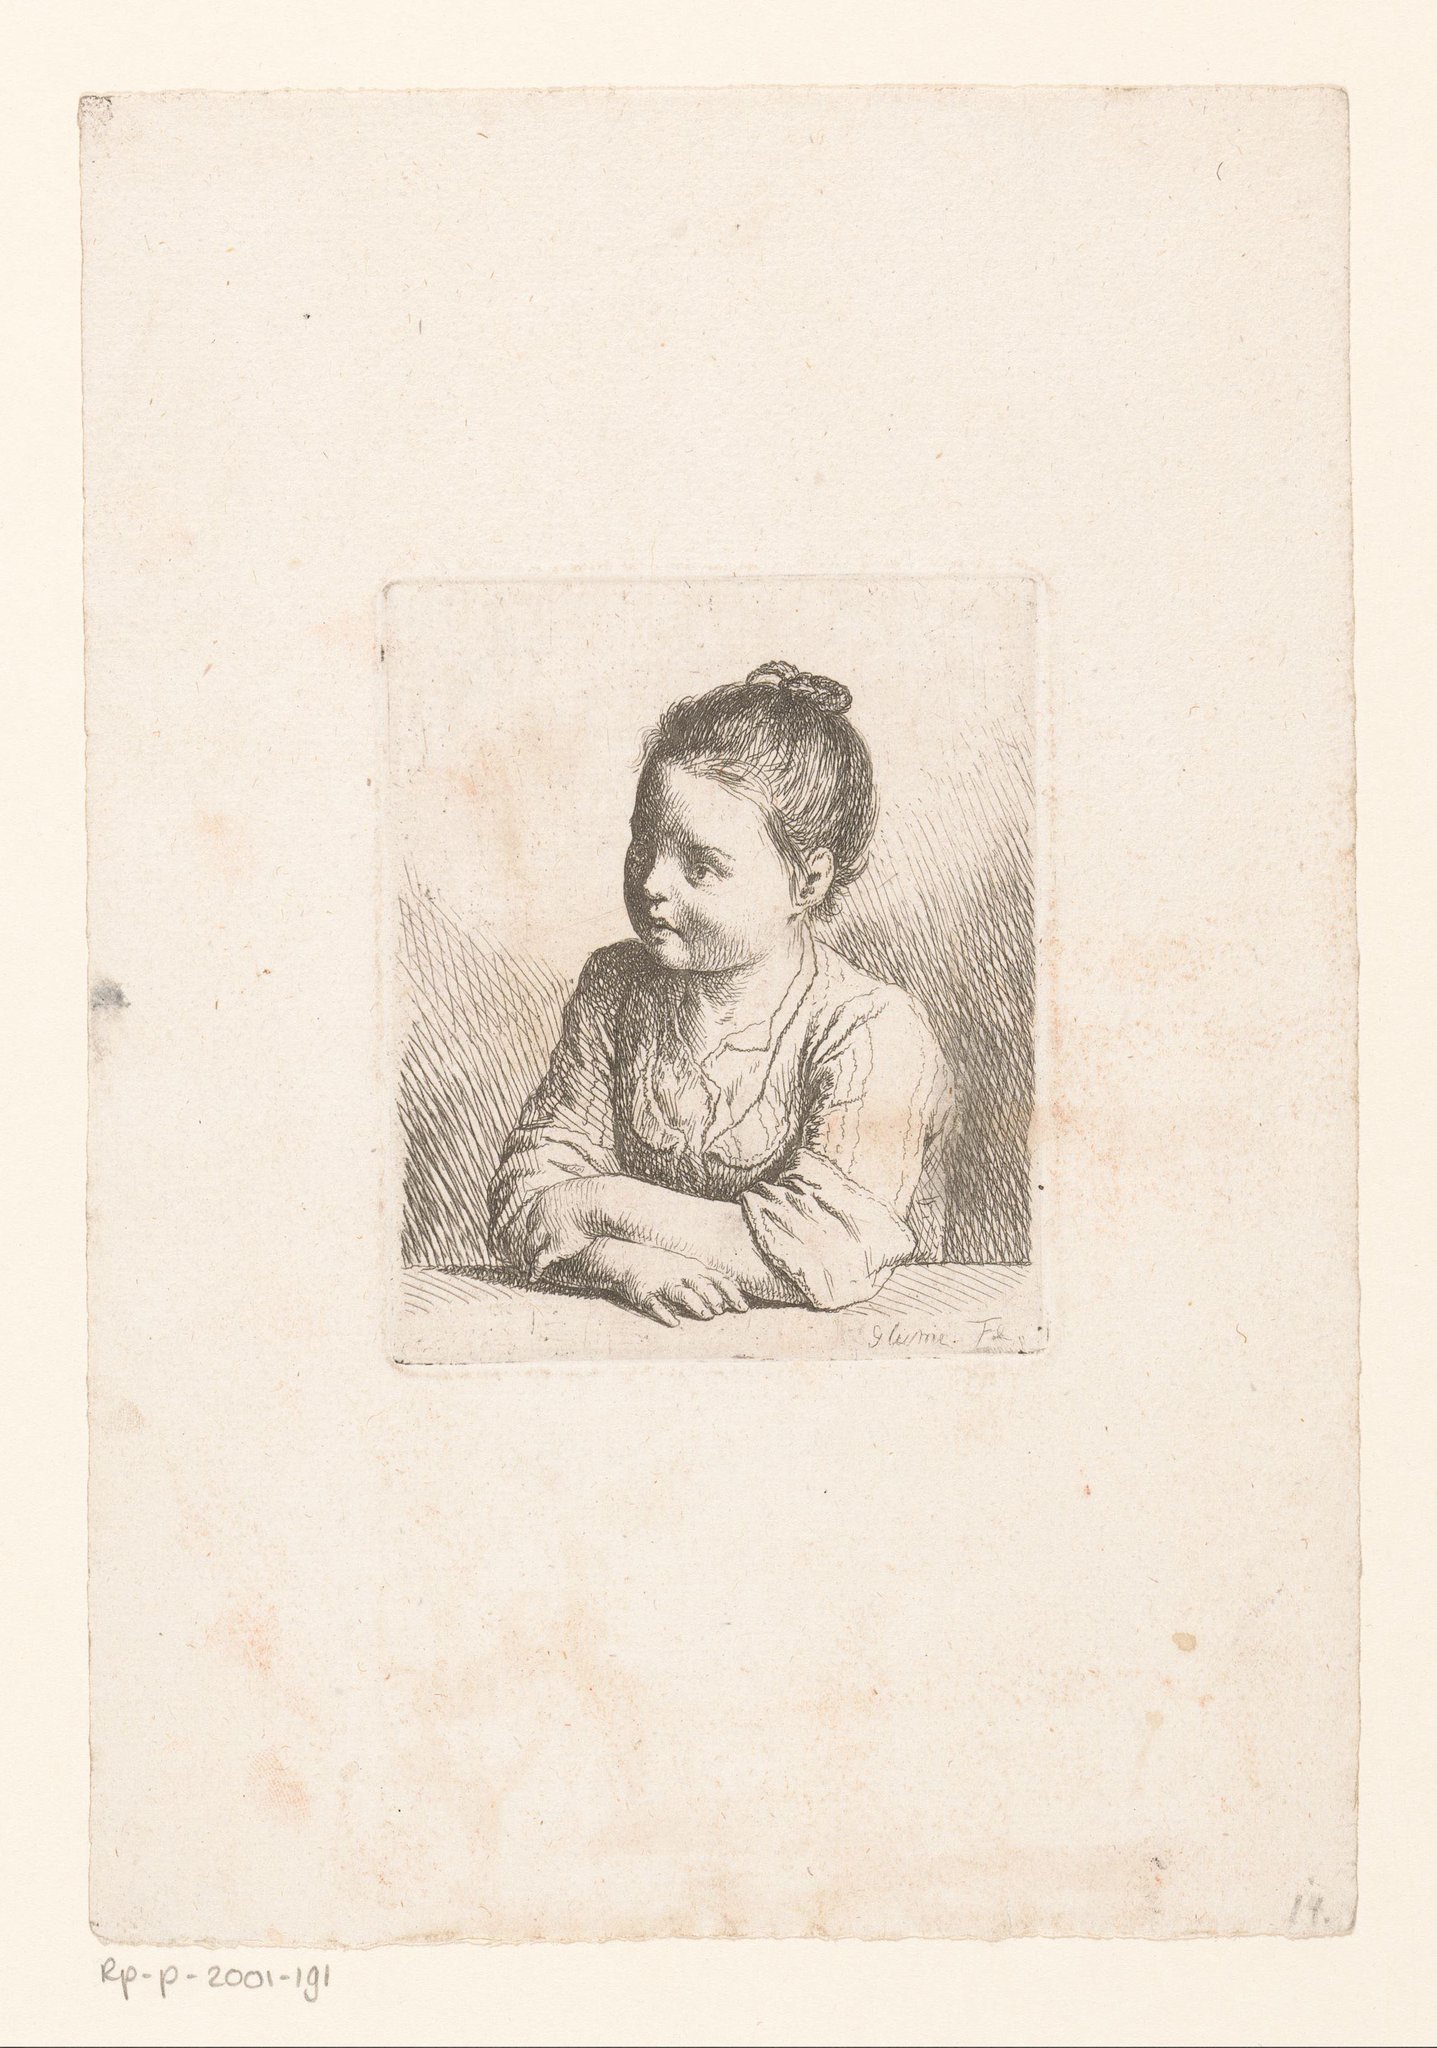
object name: print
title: Meisje met armen over elkaar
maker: johann gottlieb glume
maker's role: print maker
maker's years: 1711-1778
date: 1721-1778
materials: paper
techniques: etching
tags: arms crossed, girl (child between toddler and youth)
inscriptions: collector's mark: Lugt 3870, collector's mark: ‘S ch K’